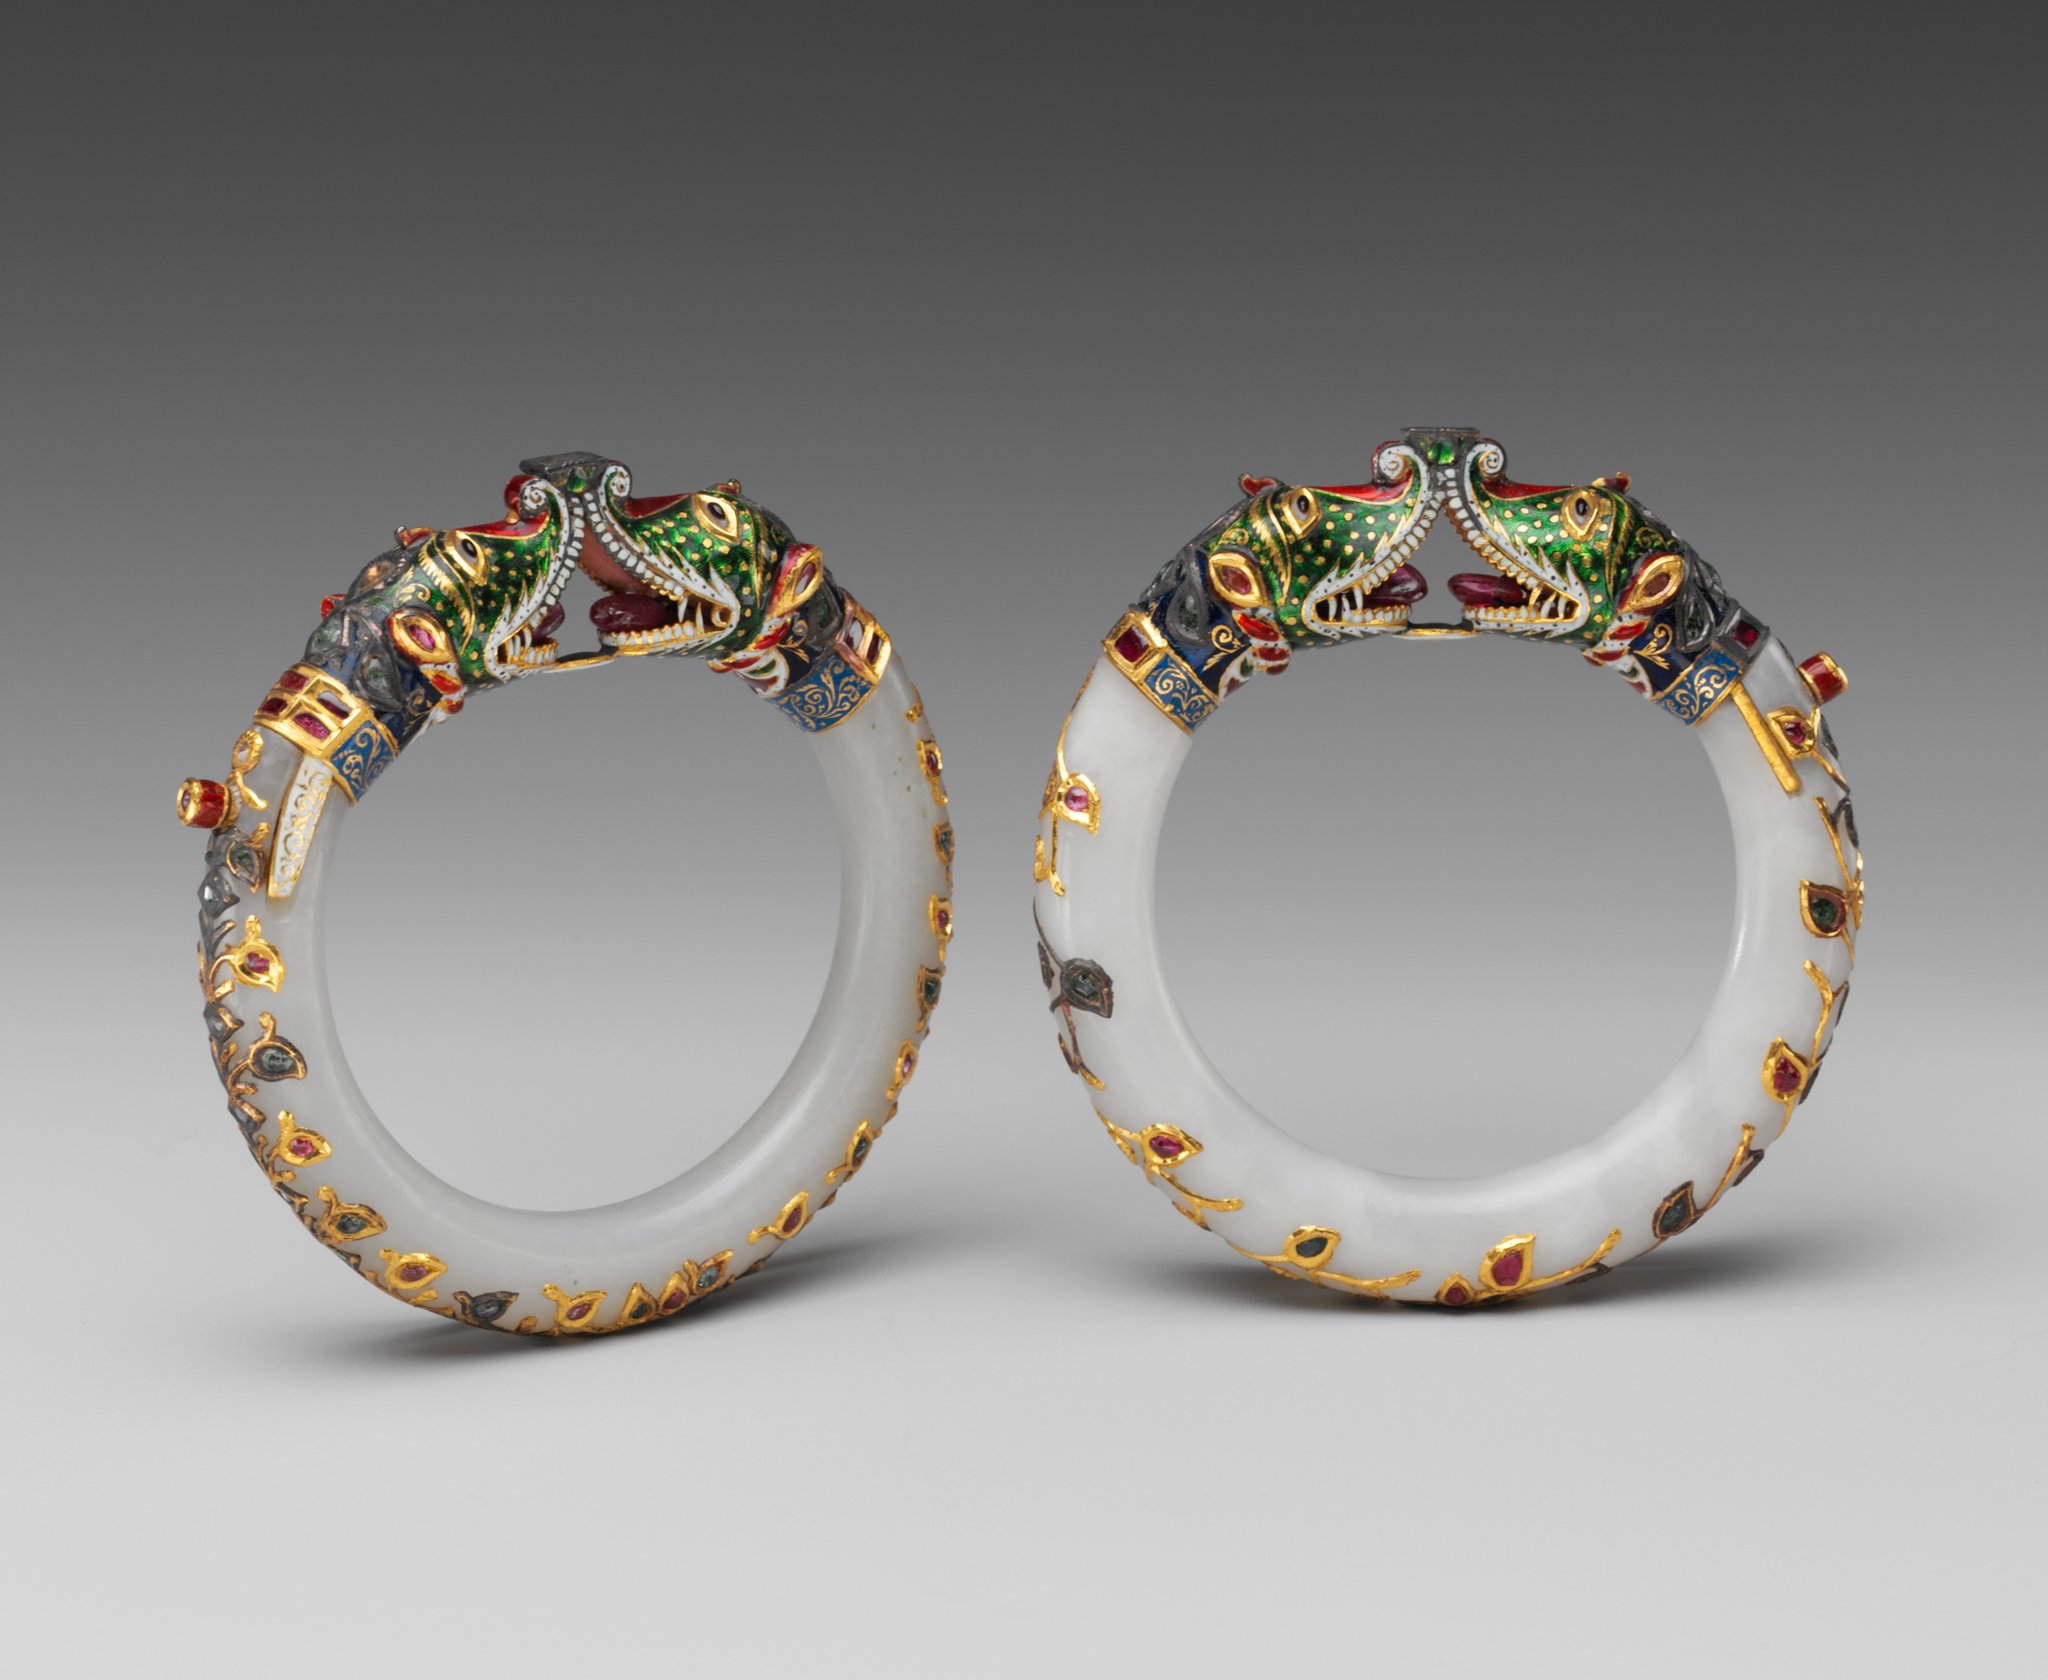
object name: bracelet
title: Bracelet (one of a pair)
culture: indian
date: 1701-1900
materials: enamel, gold, jade, stone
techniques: inlay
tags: dragons